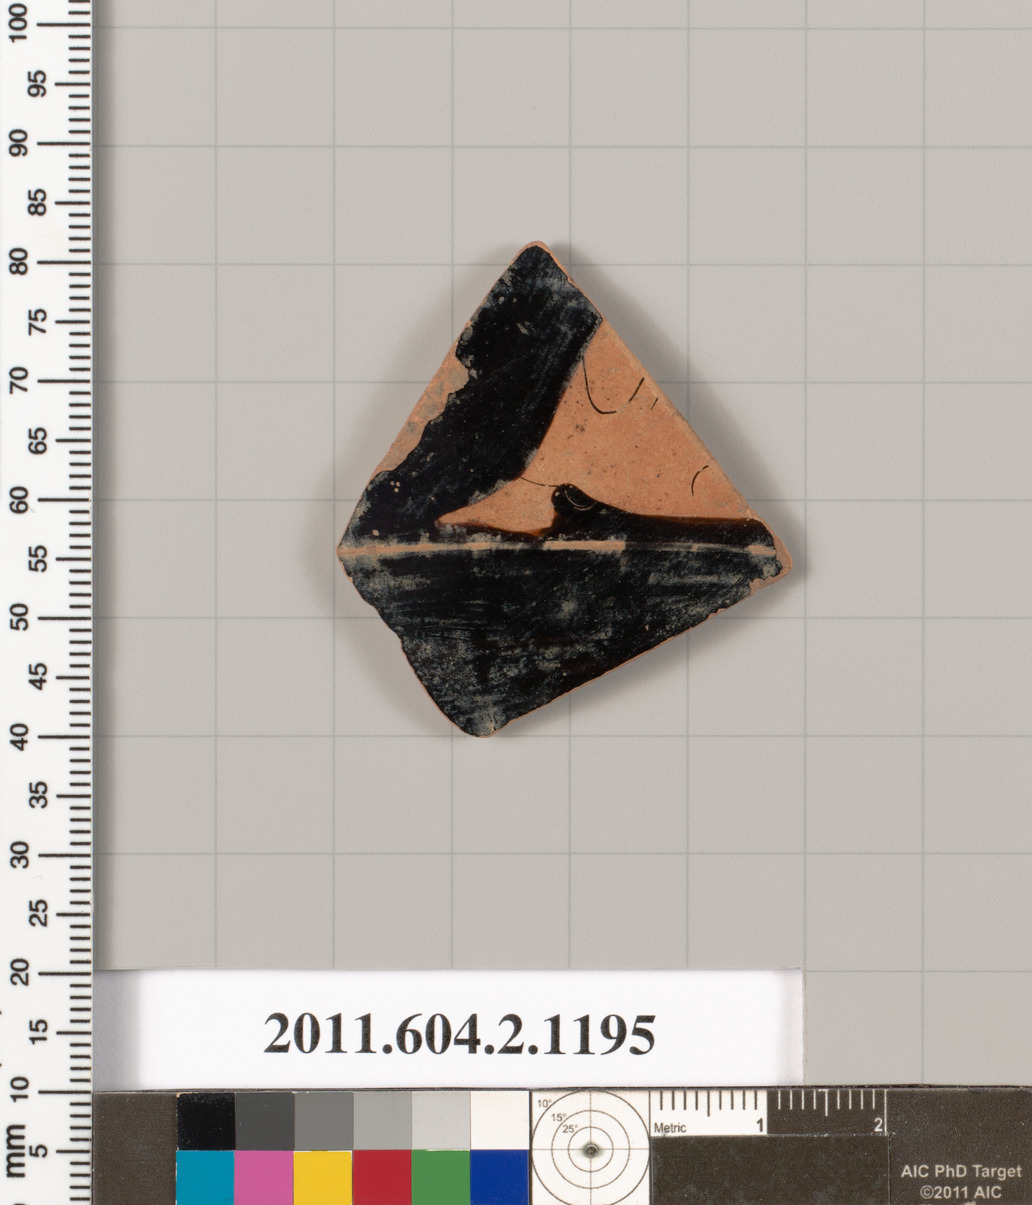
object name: chou fragment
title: Terracotta fragment of an oinochoe: chous (jug)?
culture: greek, attic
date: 450-401 BCE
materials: terracotta